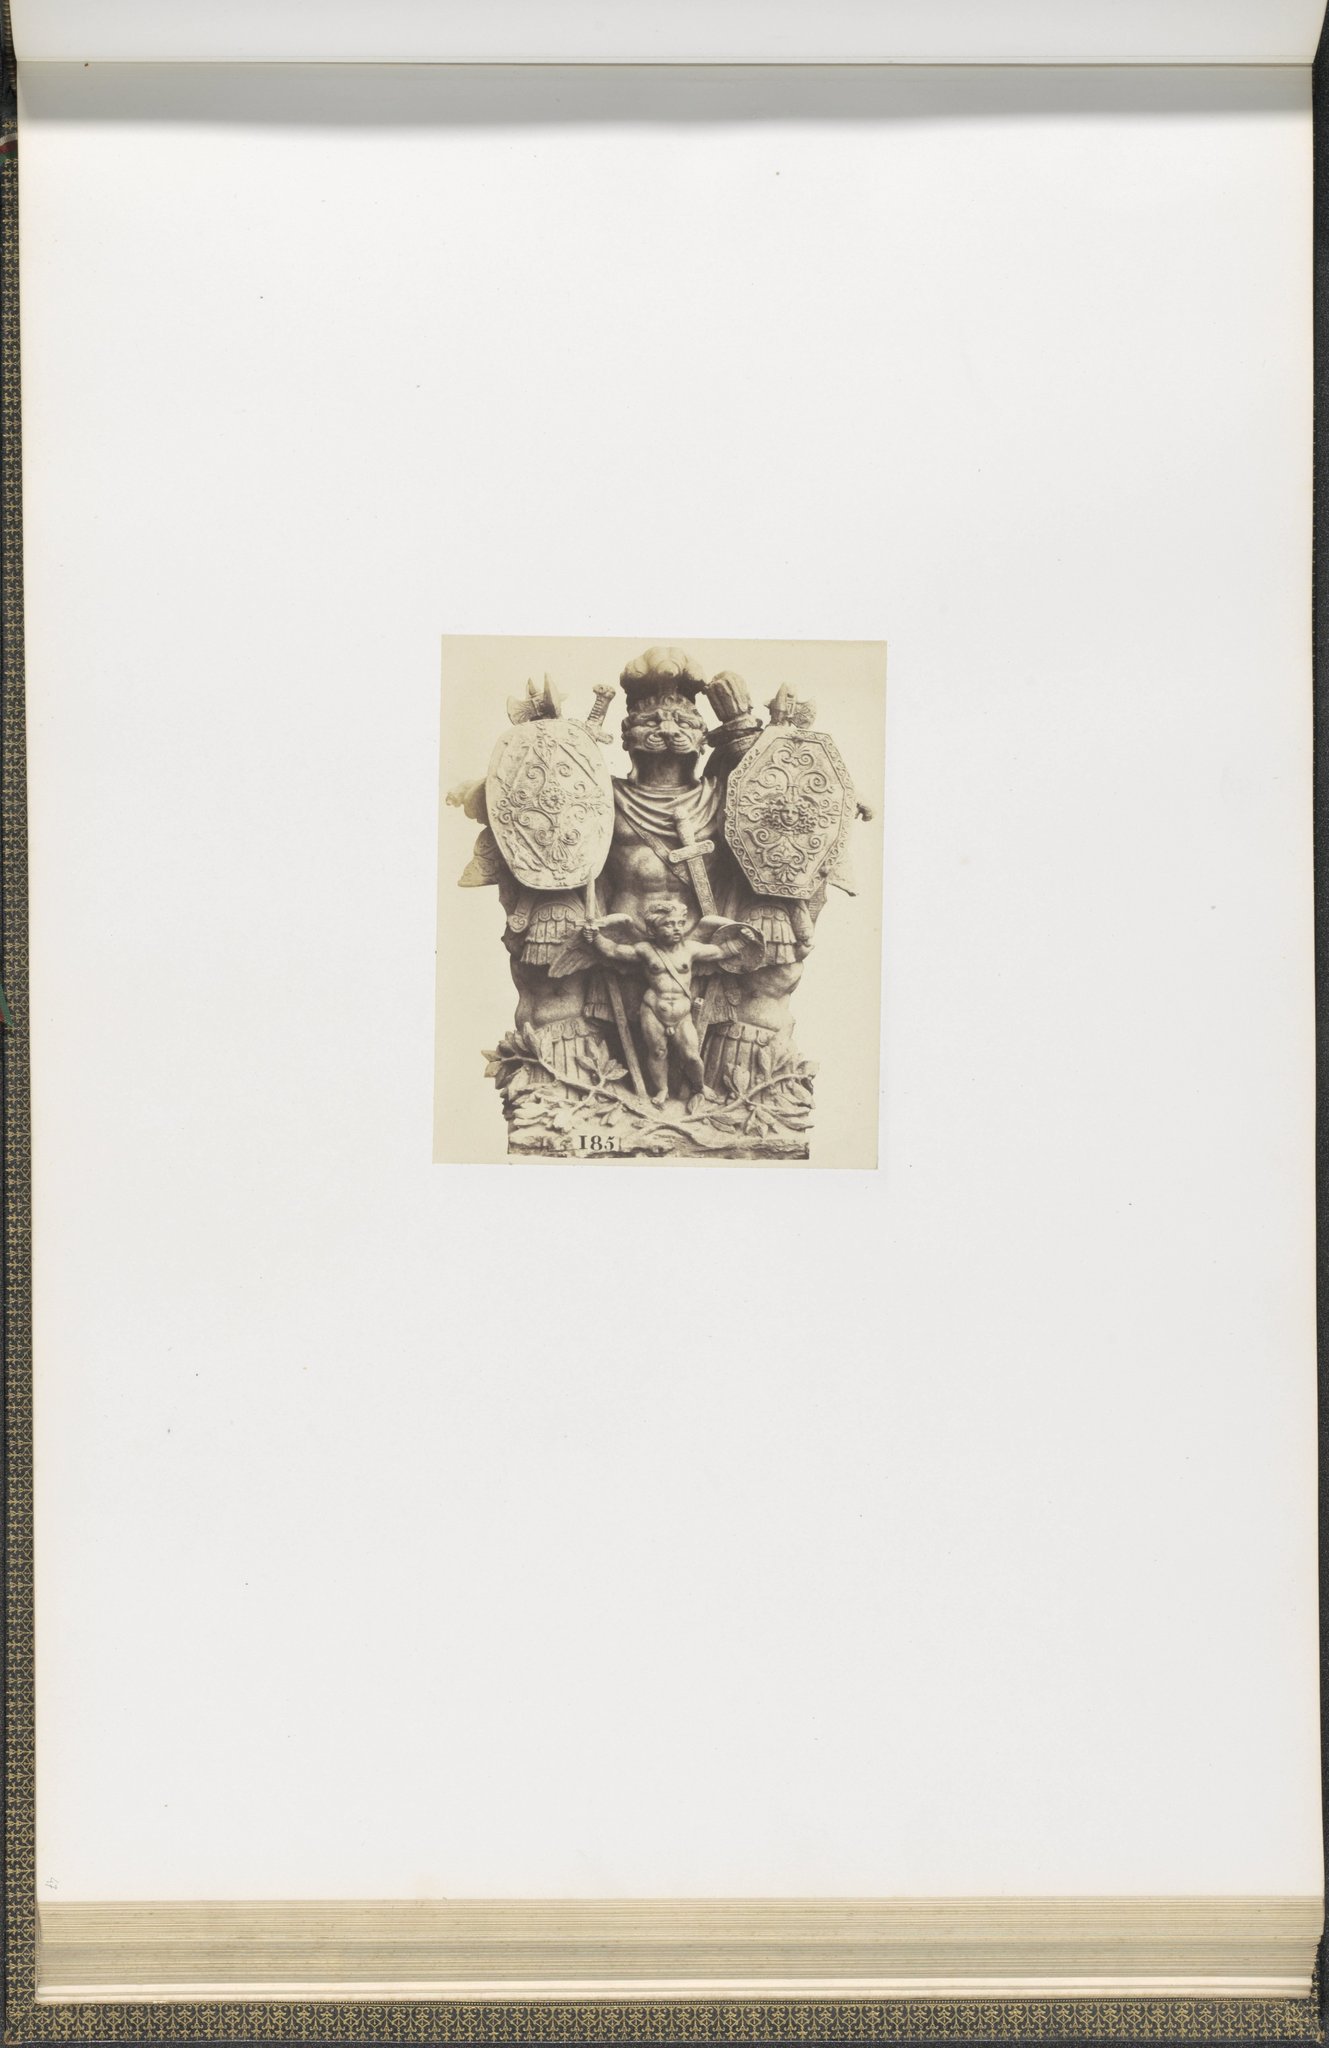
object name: album leaf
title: Gipsmodel voor beeldhouwwerk op het Palais du Louvre: "Attributs de la Guerre" door Louis Léopold Chambard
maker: édouard denis baldus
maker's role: fotograaf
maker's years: 1813-1889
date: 1855-1857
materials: paper, photographic support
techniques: salted paper print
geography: paris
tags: piece of sculpture, reproduction of a piece of sculpture, permanent exhibition, museum, paris, tuileries palace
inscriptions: number: ‘185’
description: Onderdeel van Réunion des Tuileries au Louvre 1852-1857, album 4.